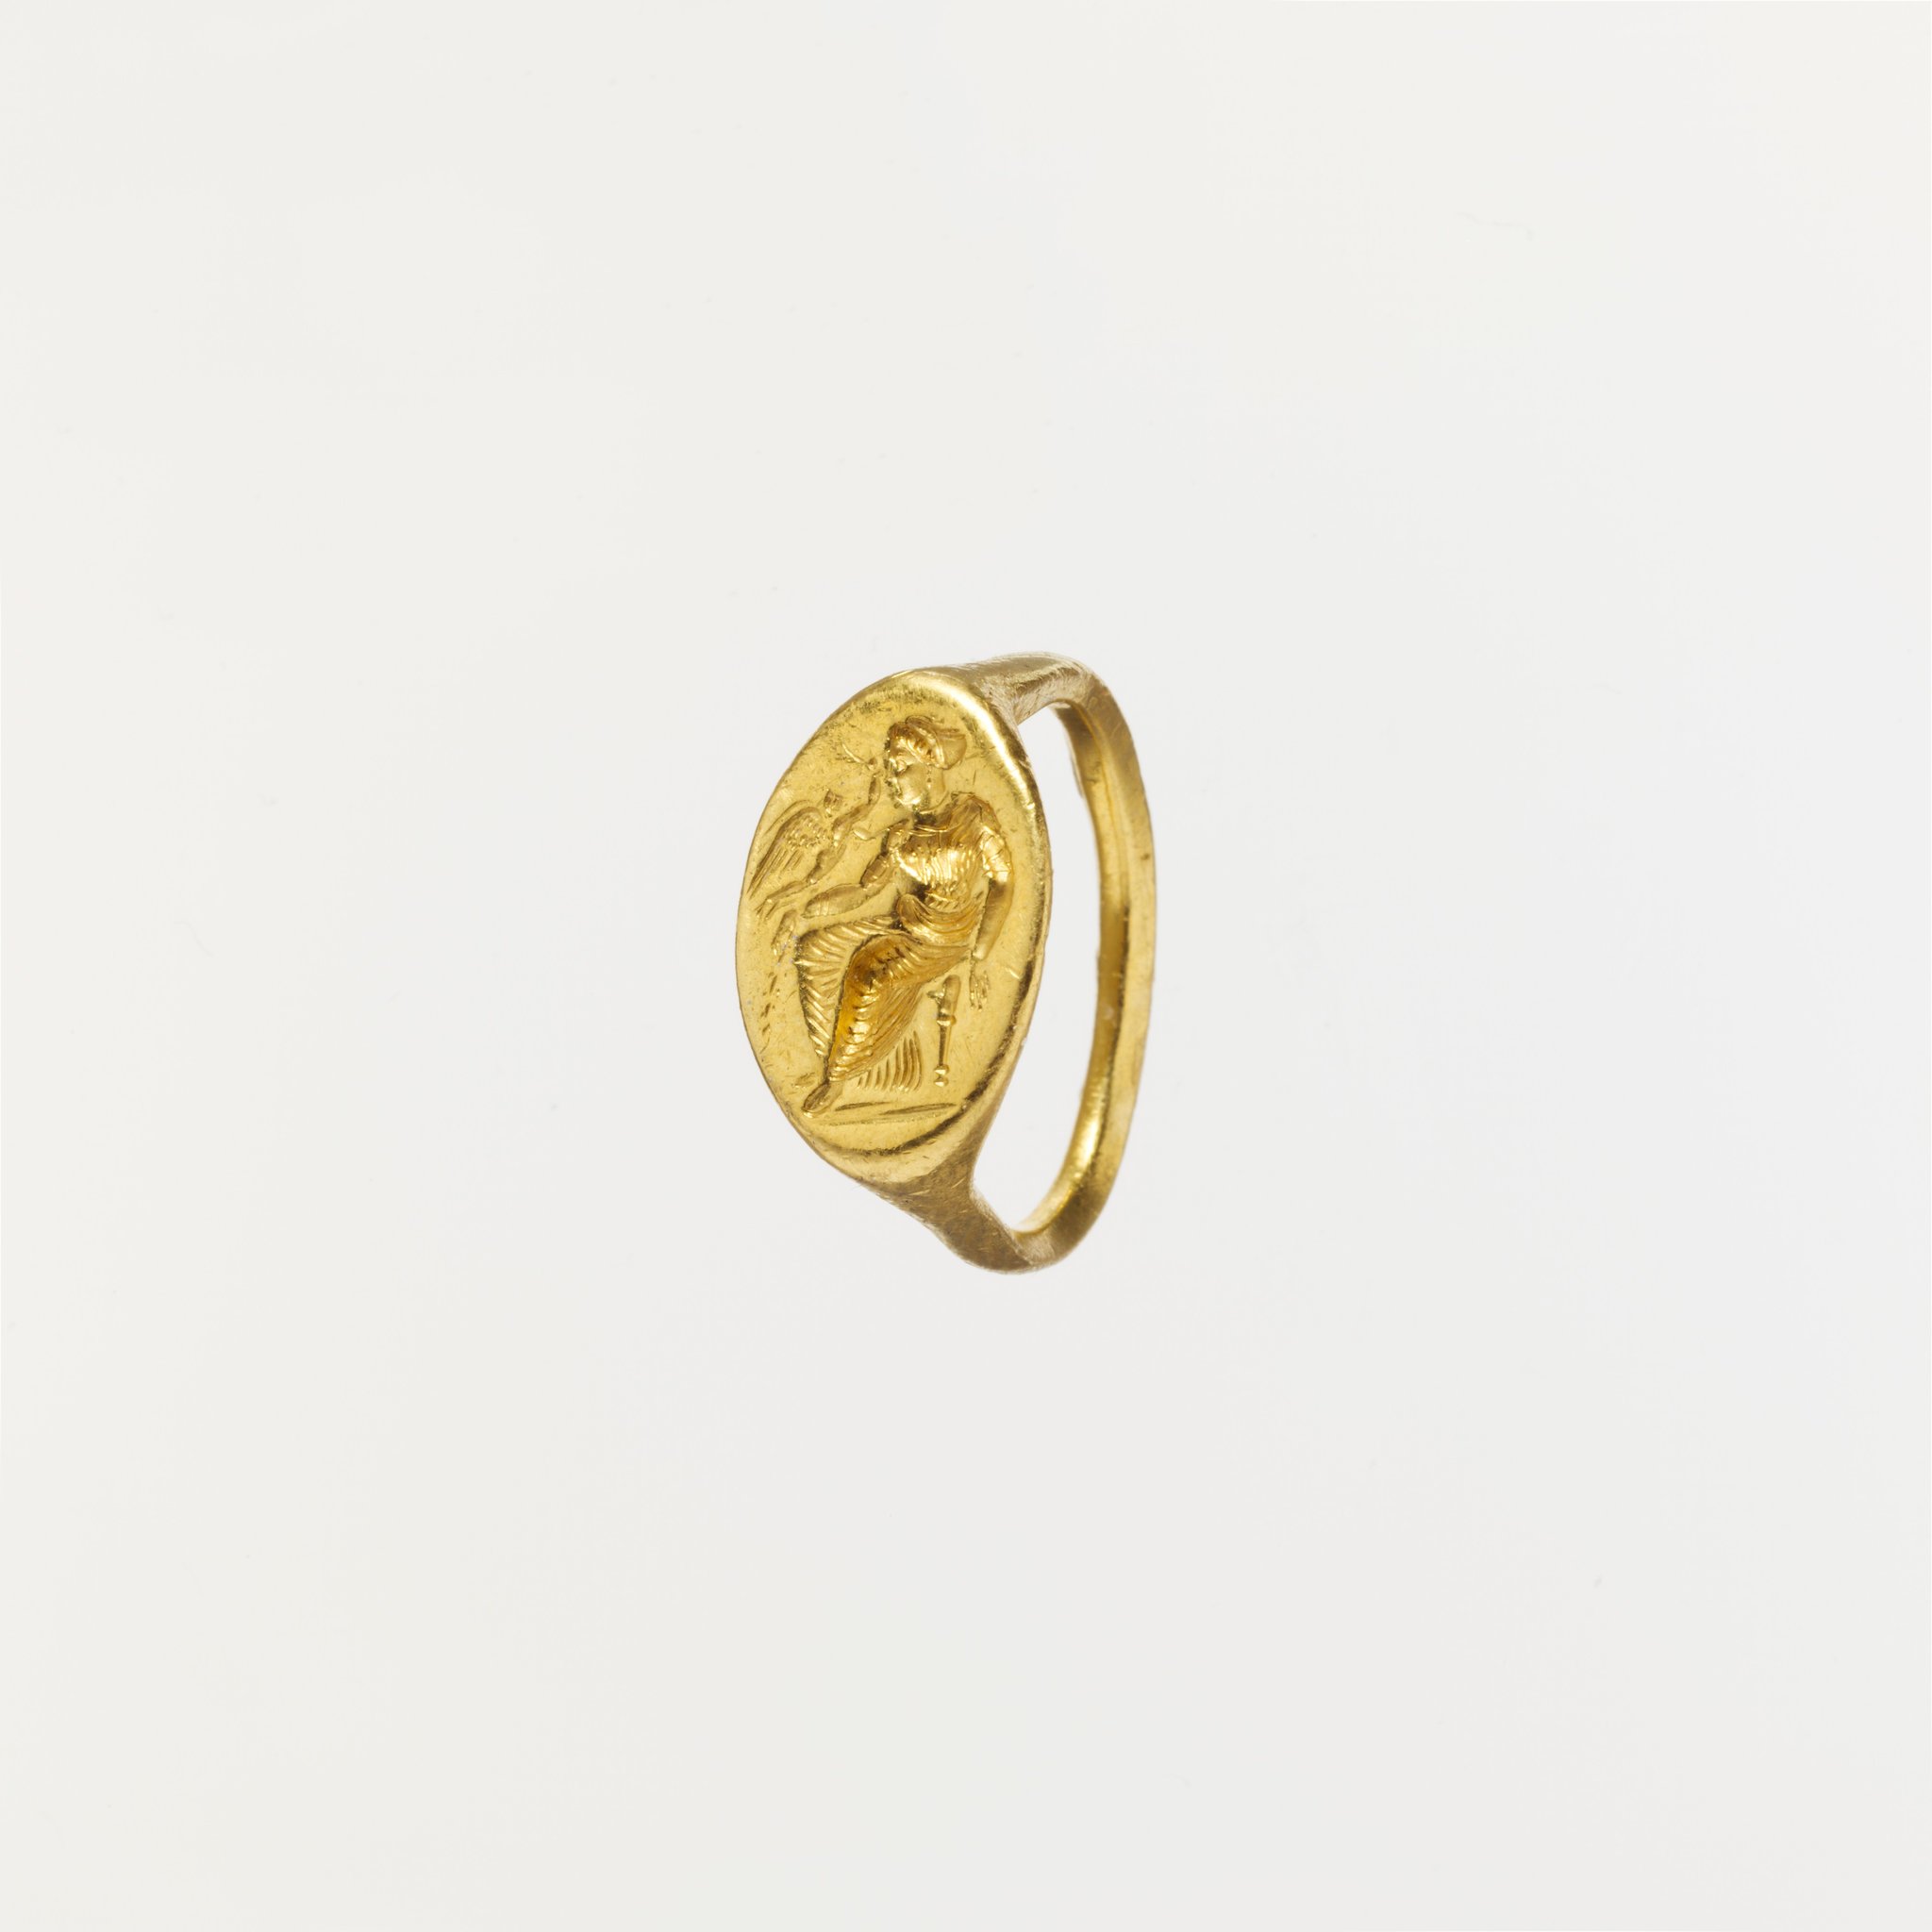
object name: ring with eros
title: Gold ring with intaglio of seated woman and flying Eros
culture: greek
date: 450-401 BCE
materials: gold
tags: women,eros